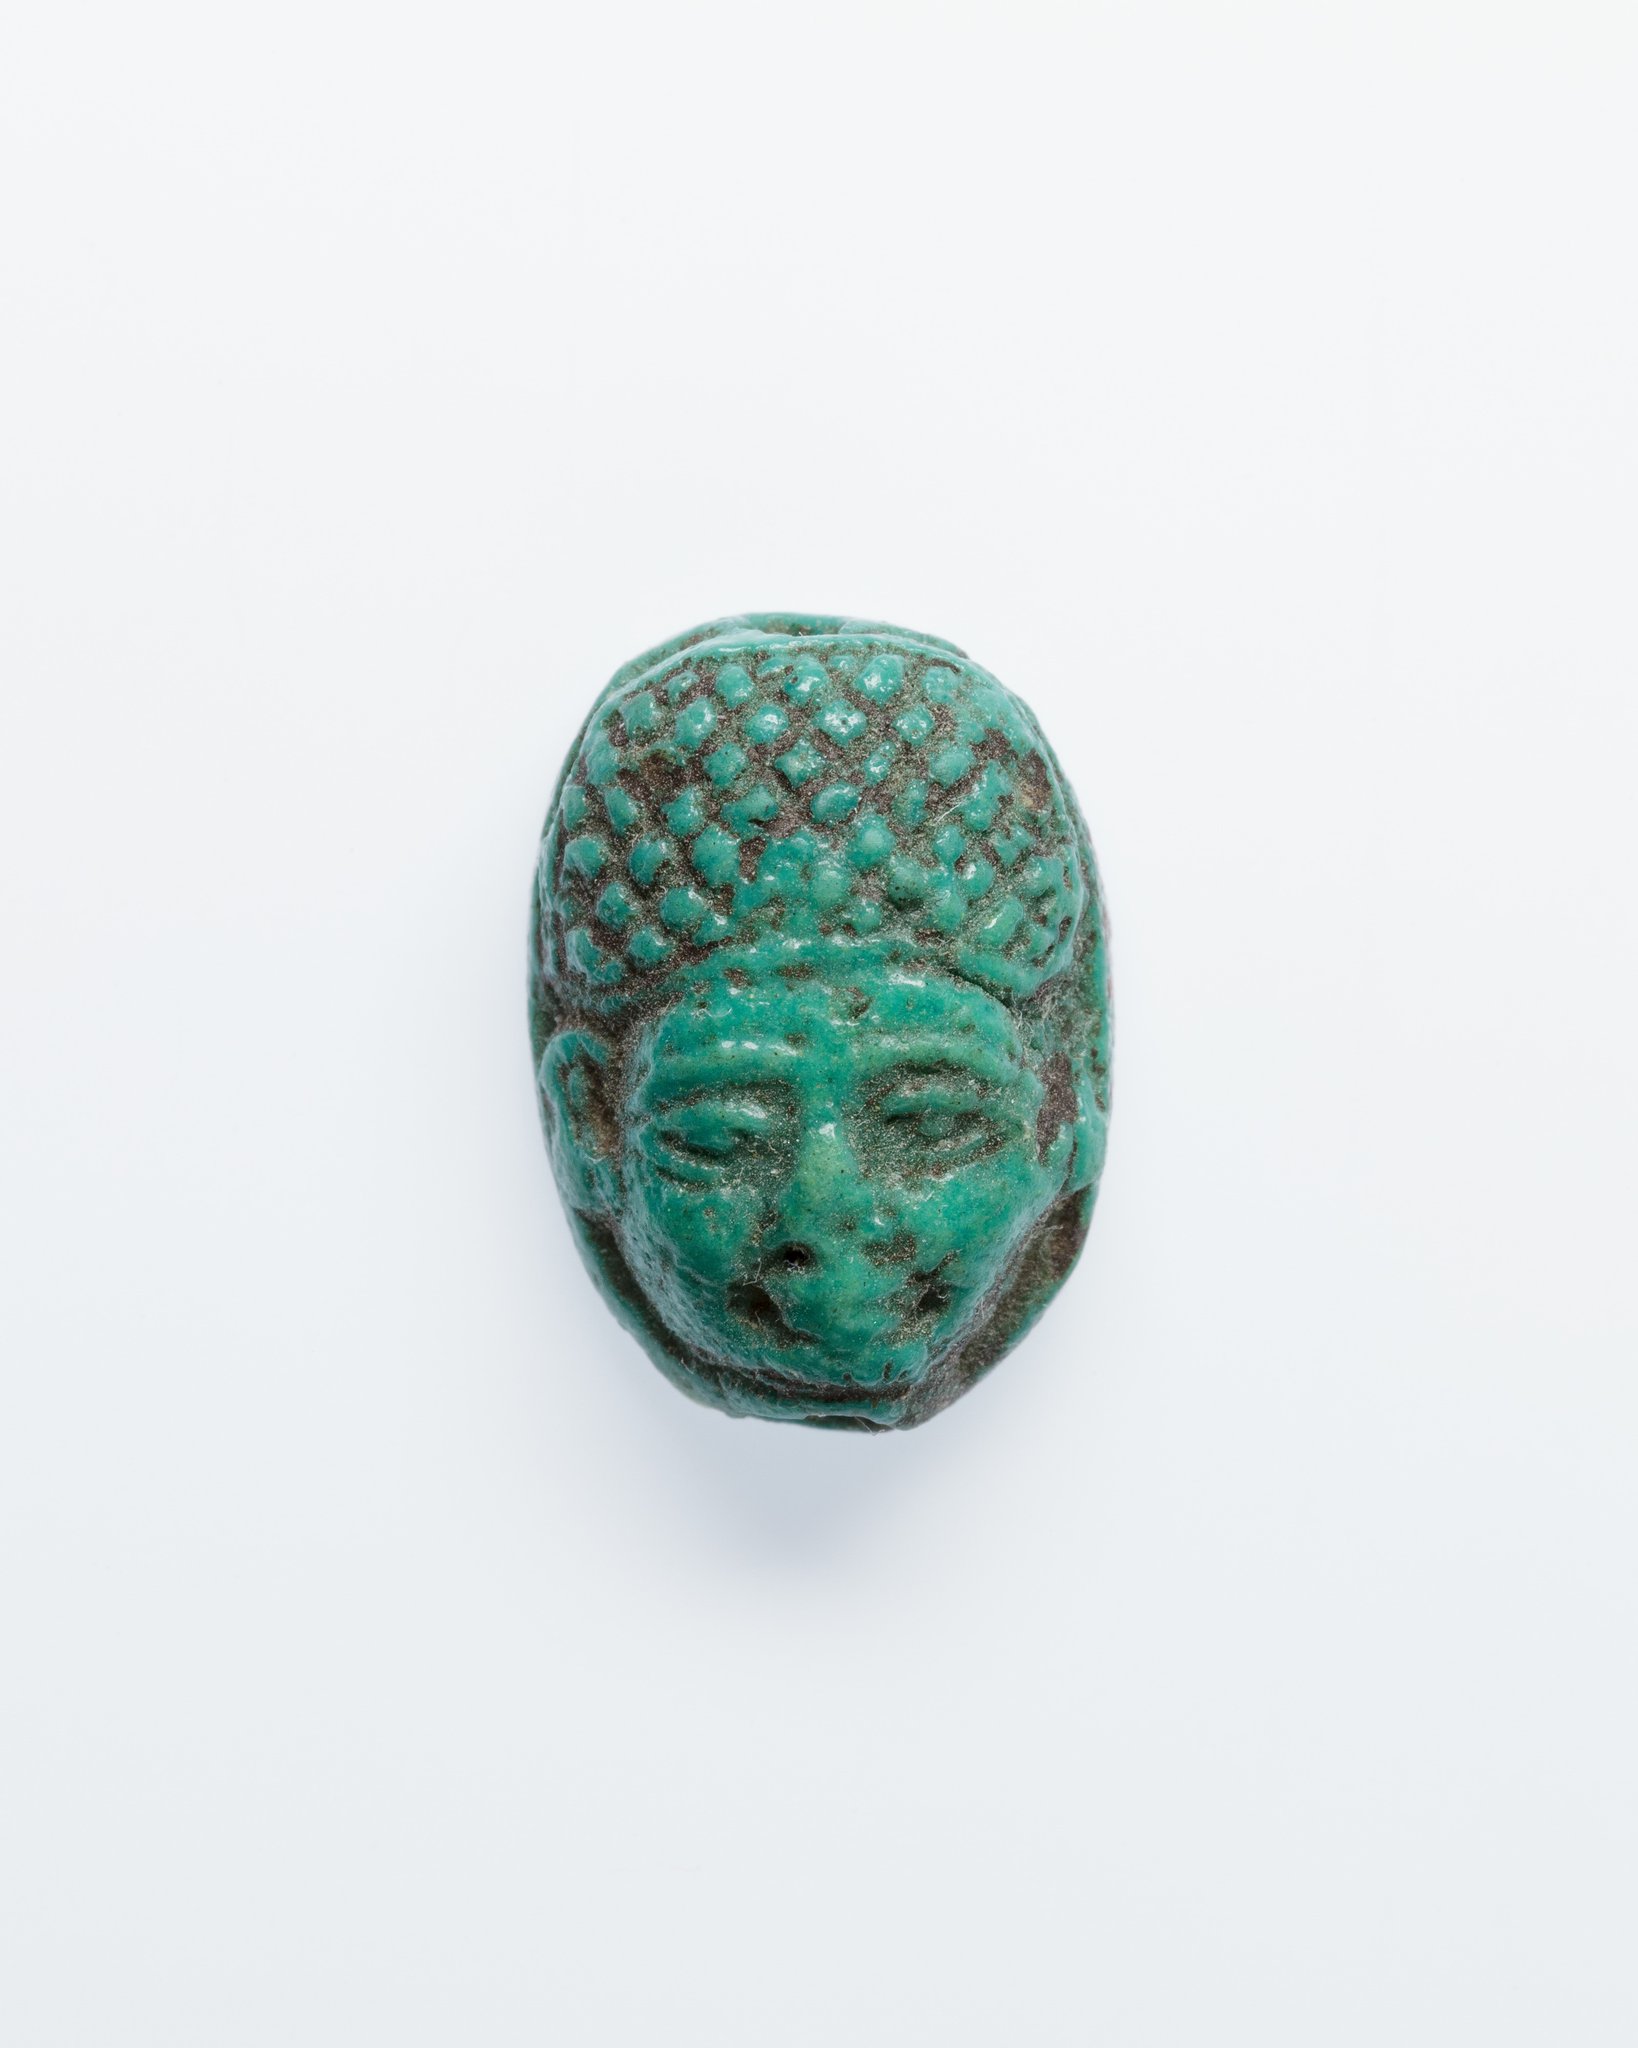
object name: stamp seal, human head scaraboid, hieroglyph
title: Human Head Scaraboid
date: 1295-1070 BCE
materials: faience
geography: egypt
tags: heads